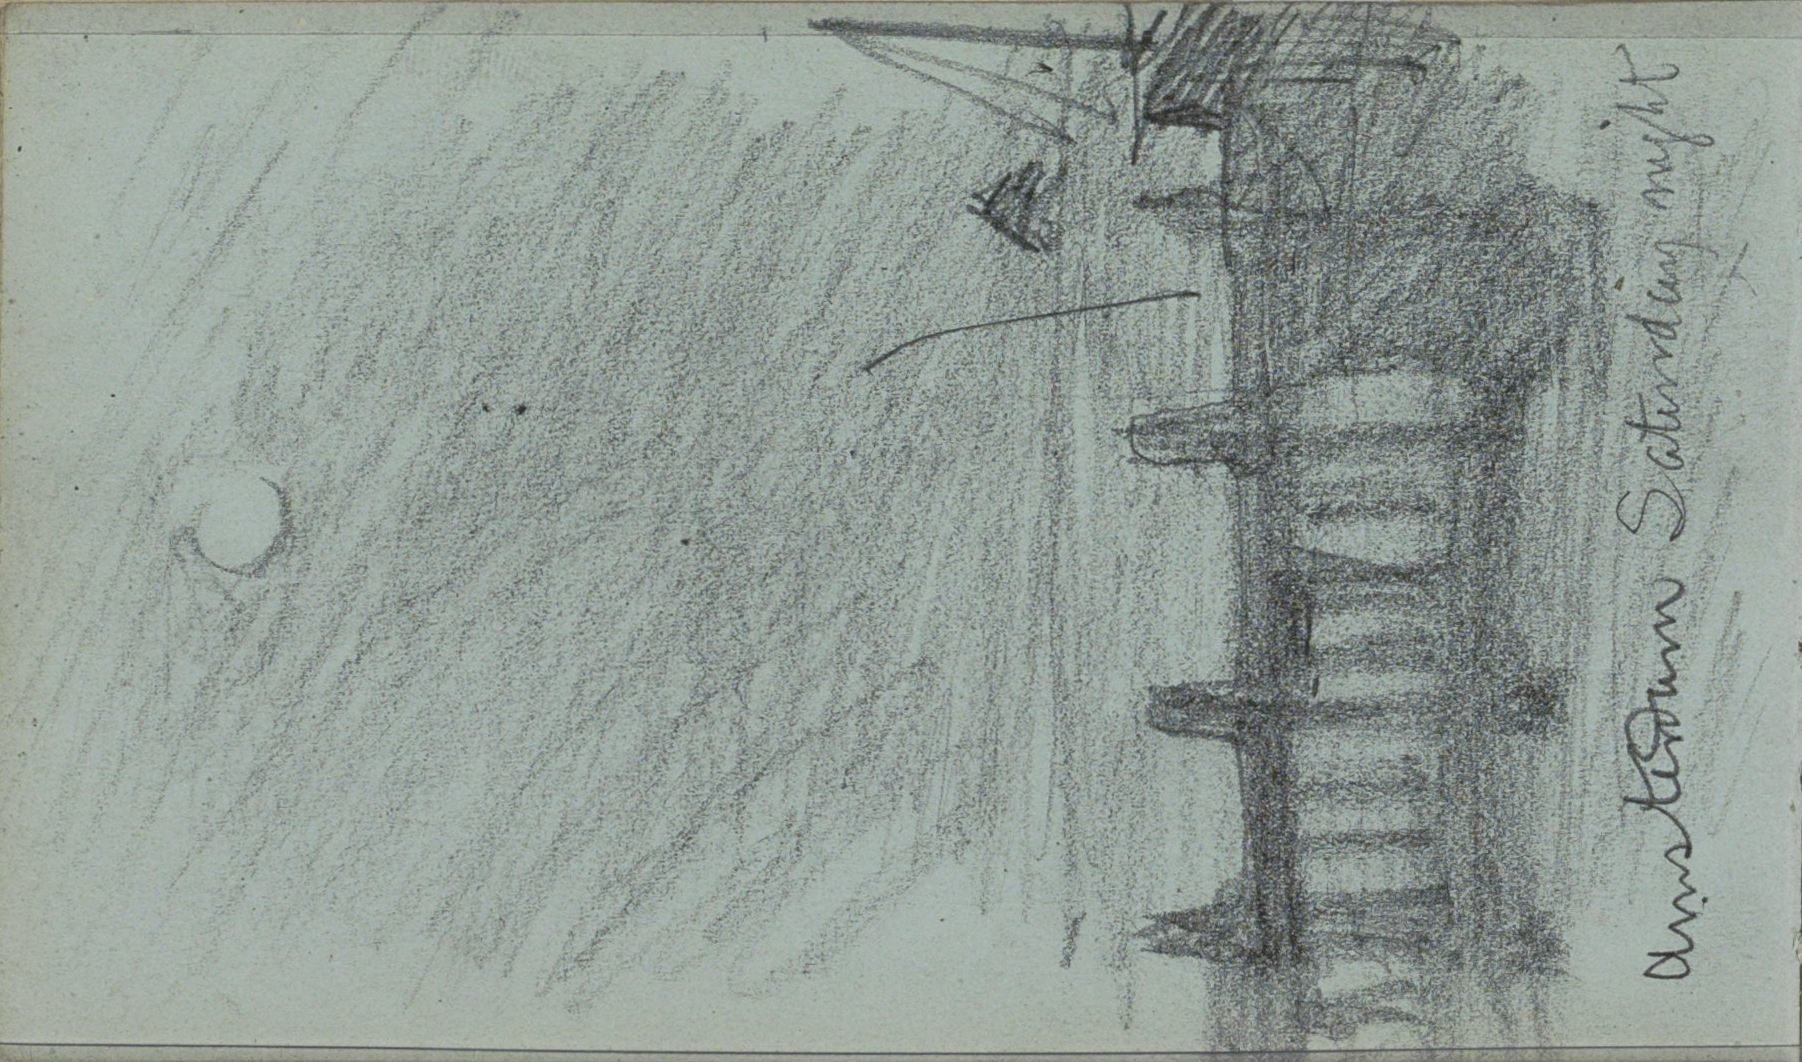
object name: sketchbook leaf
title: Gezicht op het water bij een pier in Amsterdam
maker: george clausen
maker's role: draughtsman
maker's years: 1852-1912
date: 1875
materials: paper, pencil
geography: amsterdam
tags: landscapes with waters, waterscapes, seascapes (in the temperate zone), pier, quay, wharf, amsterdam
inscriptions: annotation: ‘amsterdam Saturday night’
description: Blad 28 verso uit een schetsboek met 46 bladen.